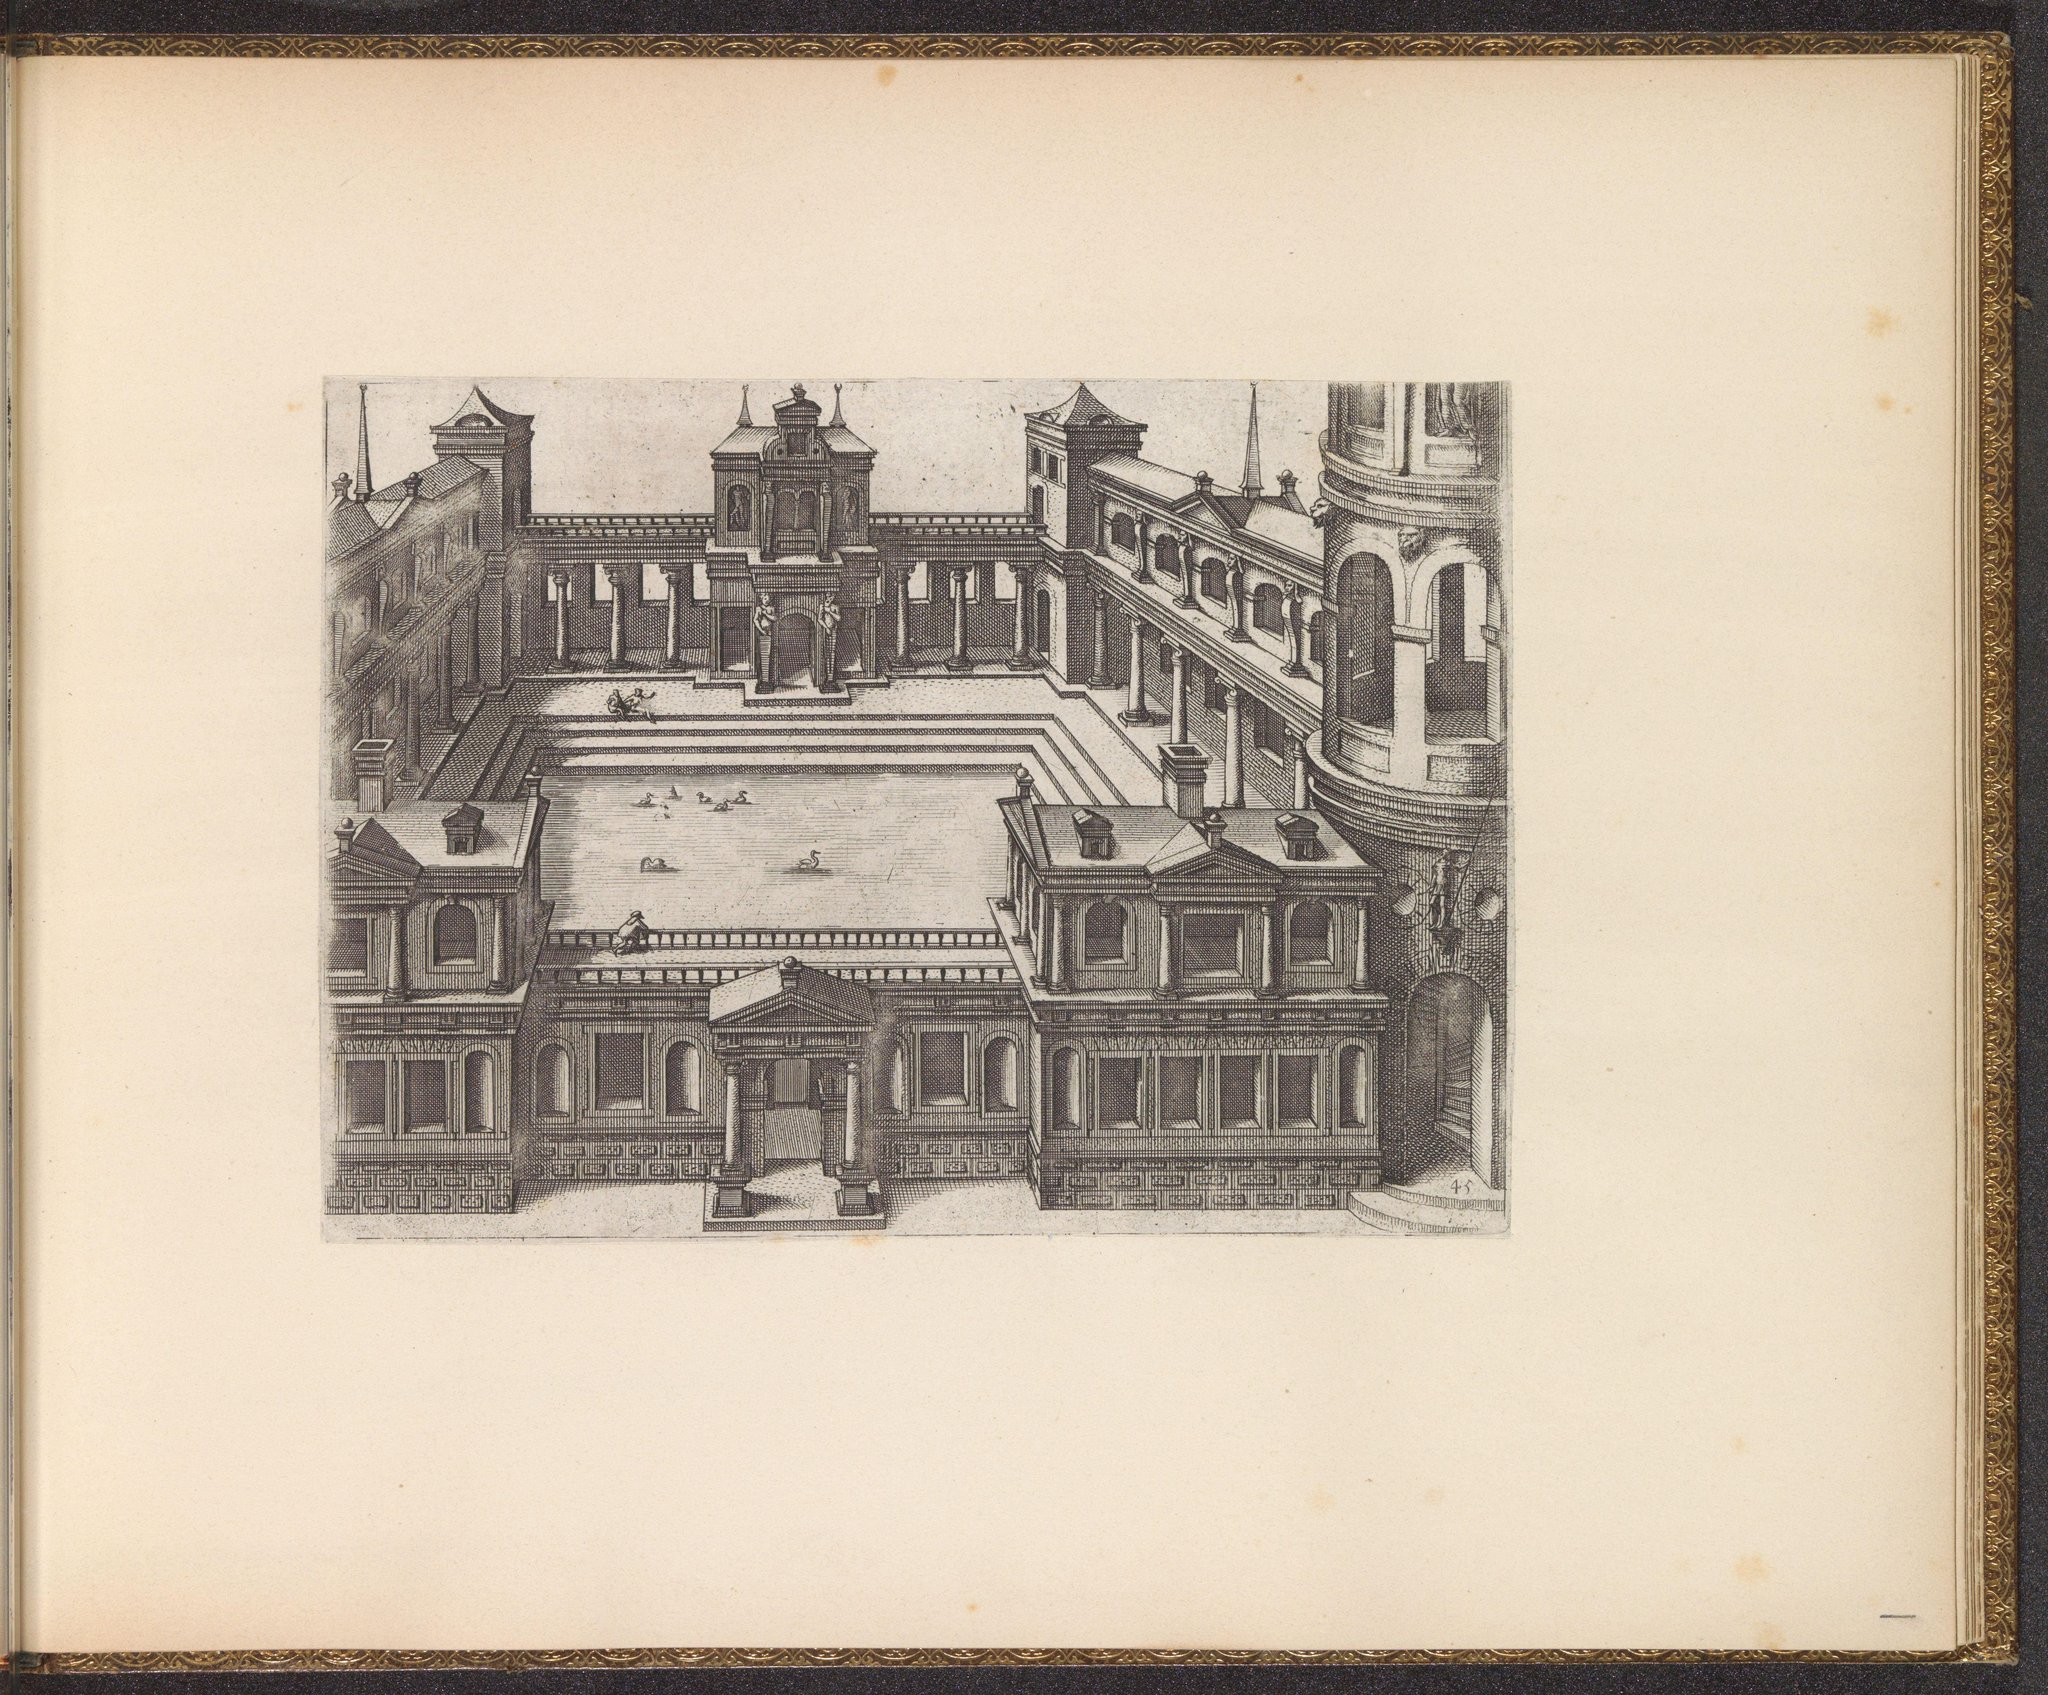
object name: ornament print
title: Binnenplaats van een paleis met waterbassin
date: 1601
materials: paper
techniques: etching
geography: antwerp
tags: palace, inner court of palace or 'hôtel'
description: Binnenplaats van een paleis in semi-vogelvlucht. In het midden ligt een groot bassin, waar drie treden naar toe leiden. In het bassin zwemmen vogels. De prent maakt deel uit van een album.